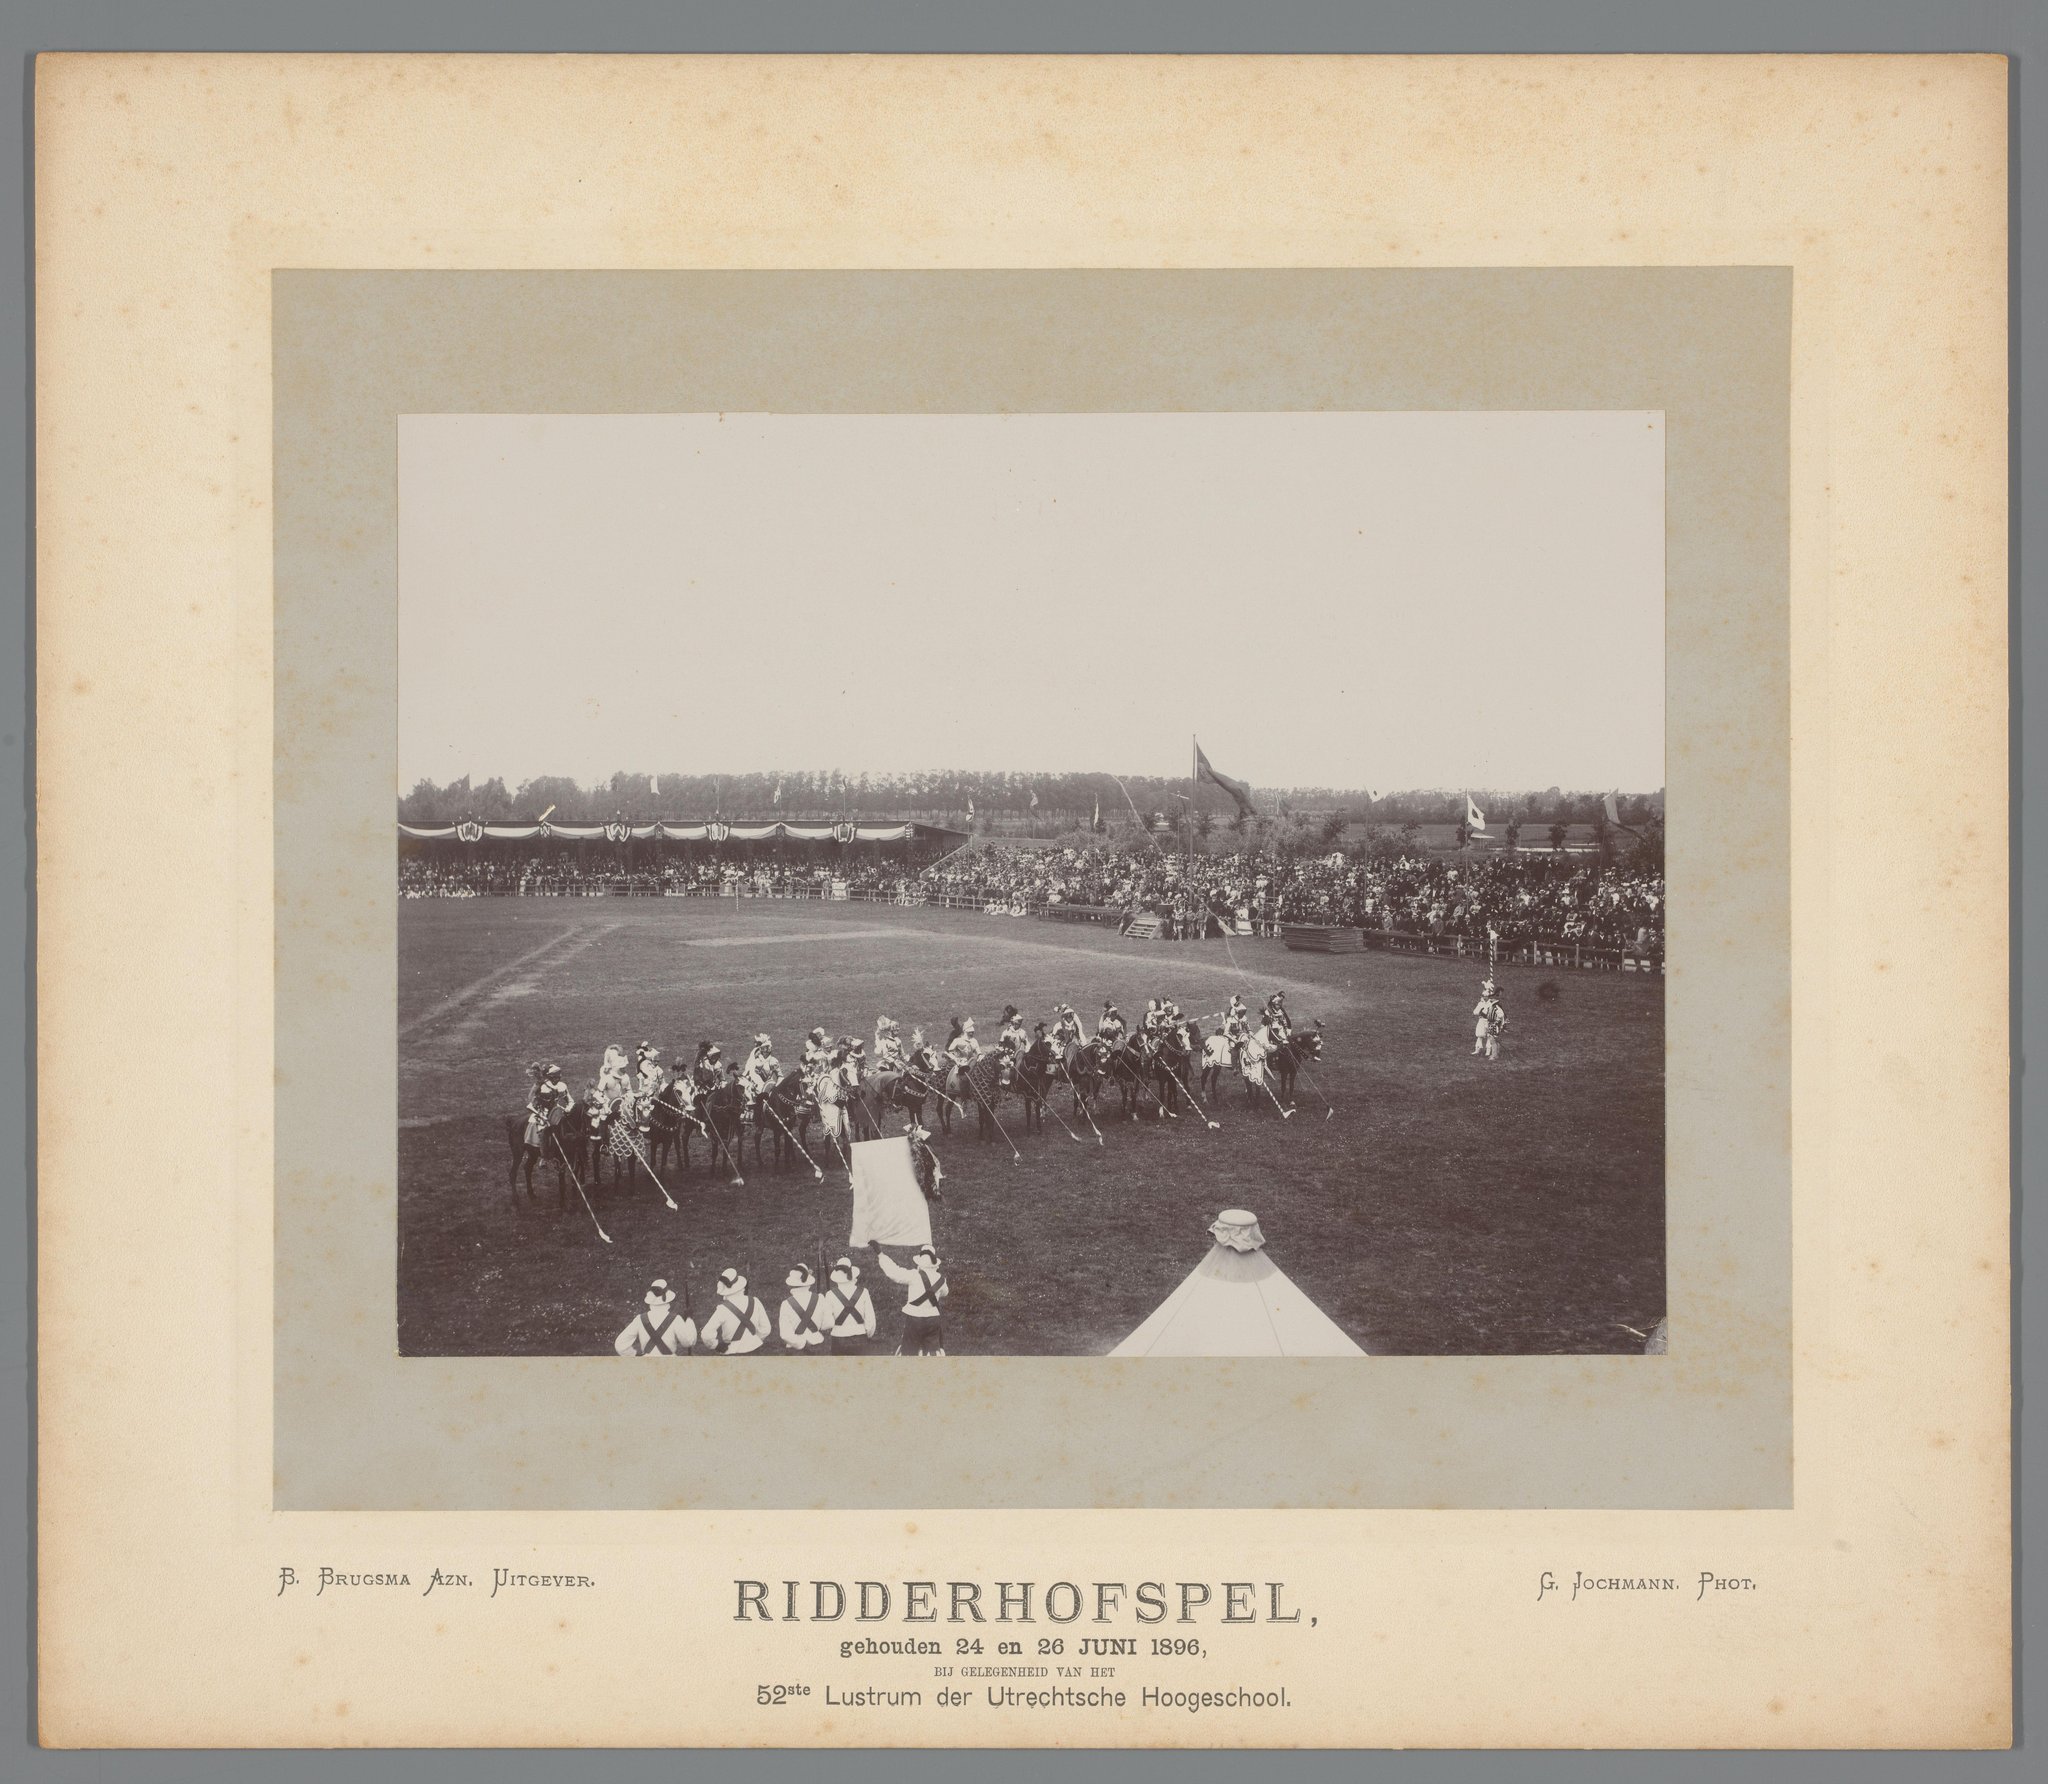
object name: photograph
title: Opstelling van deelnemers in de arena tijdens de Ridderhofspelen op 24 en 26 juni 1896 in Utrecht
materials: cardboard, paper, photographic support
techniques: collodion silver print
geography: utrecht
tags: (medieval) fighting contest, public festivities, utrecht